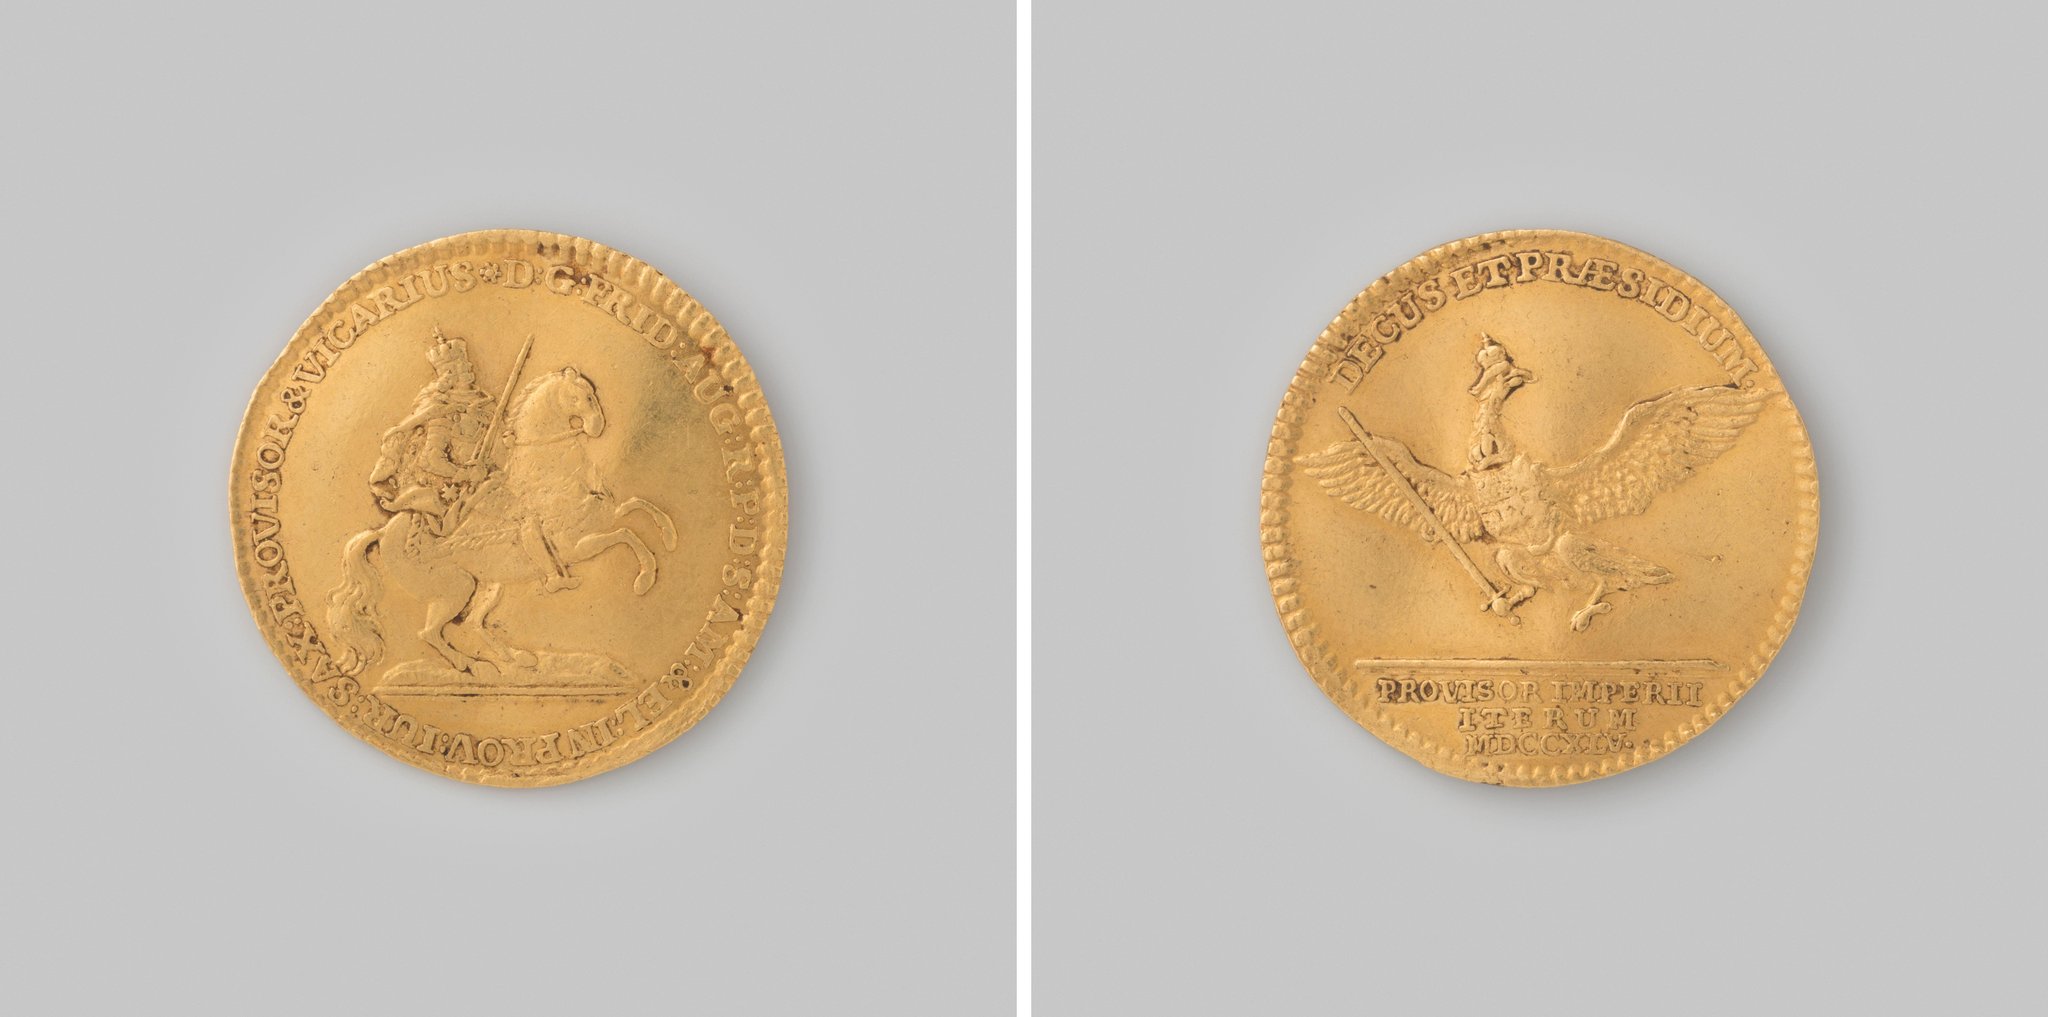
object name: ducat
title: Saksen, Albertinische Linie, Friedrich August II, dukaat,1745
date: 1745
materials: gold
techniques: striking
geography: leipzig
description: Gouden munt. Voorzijde: gekroonde vorst te paard met in rechterhand zwaard naar rechts. Keerzijde: gekroonde vliegende adelaar naar links, met in rechterklauw zwaard en met gekroond wapenschild op de borst. In afsnede jaartal in Romeinse cijfers. Kabelrand. Muntplaatje licht gebogen.